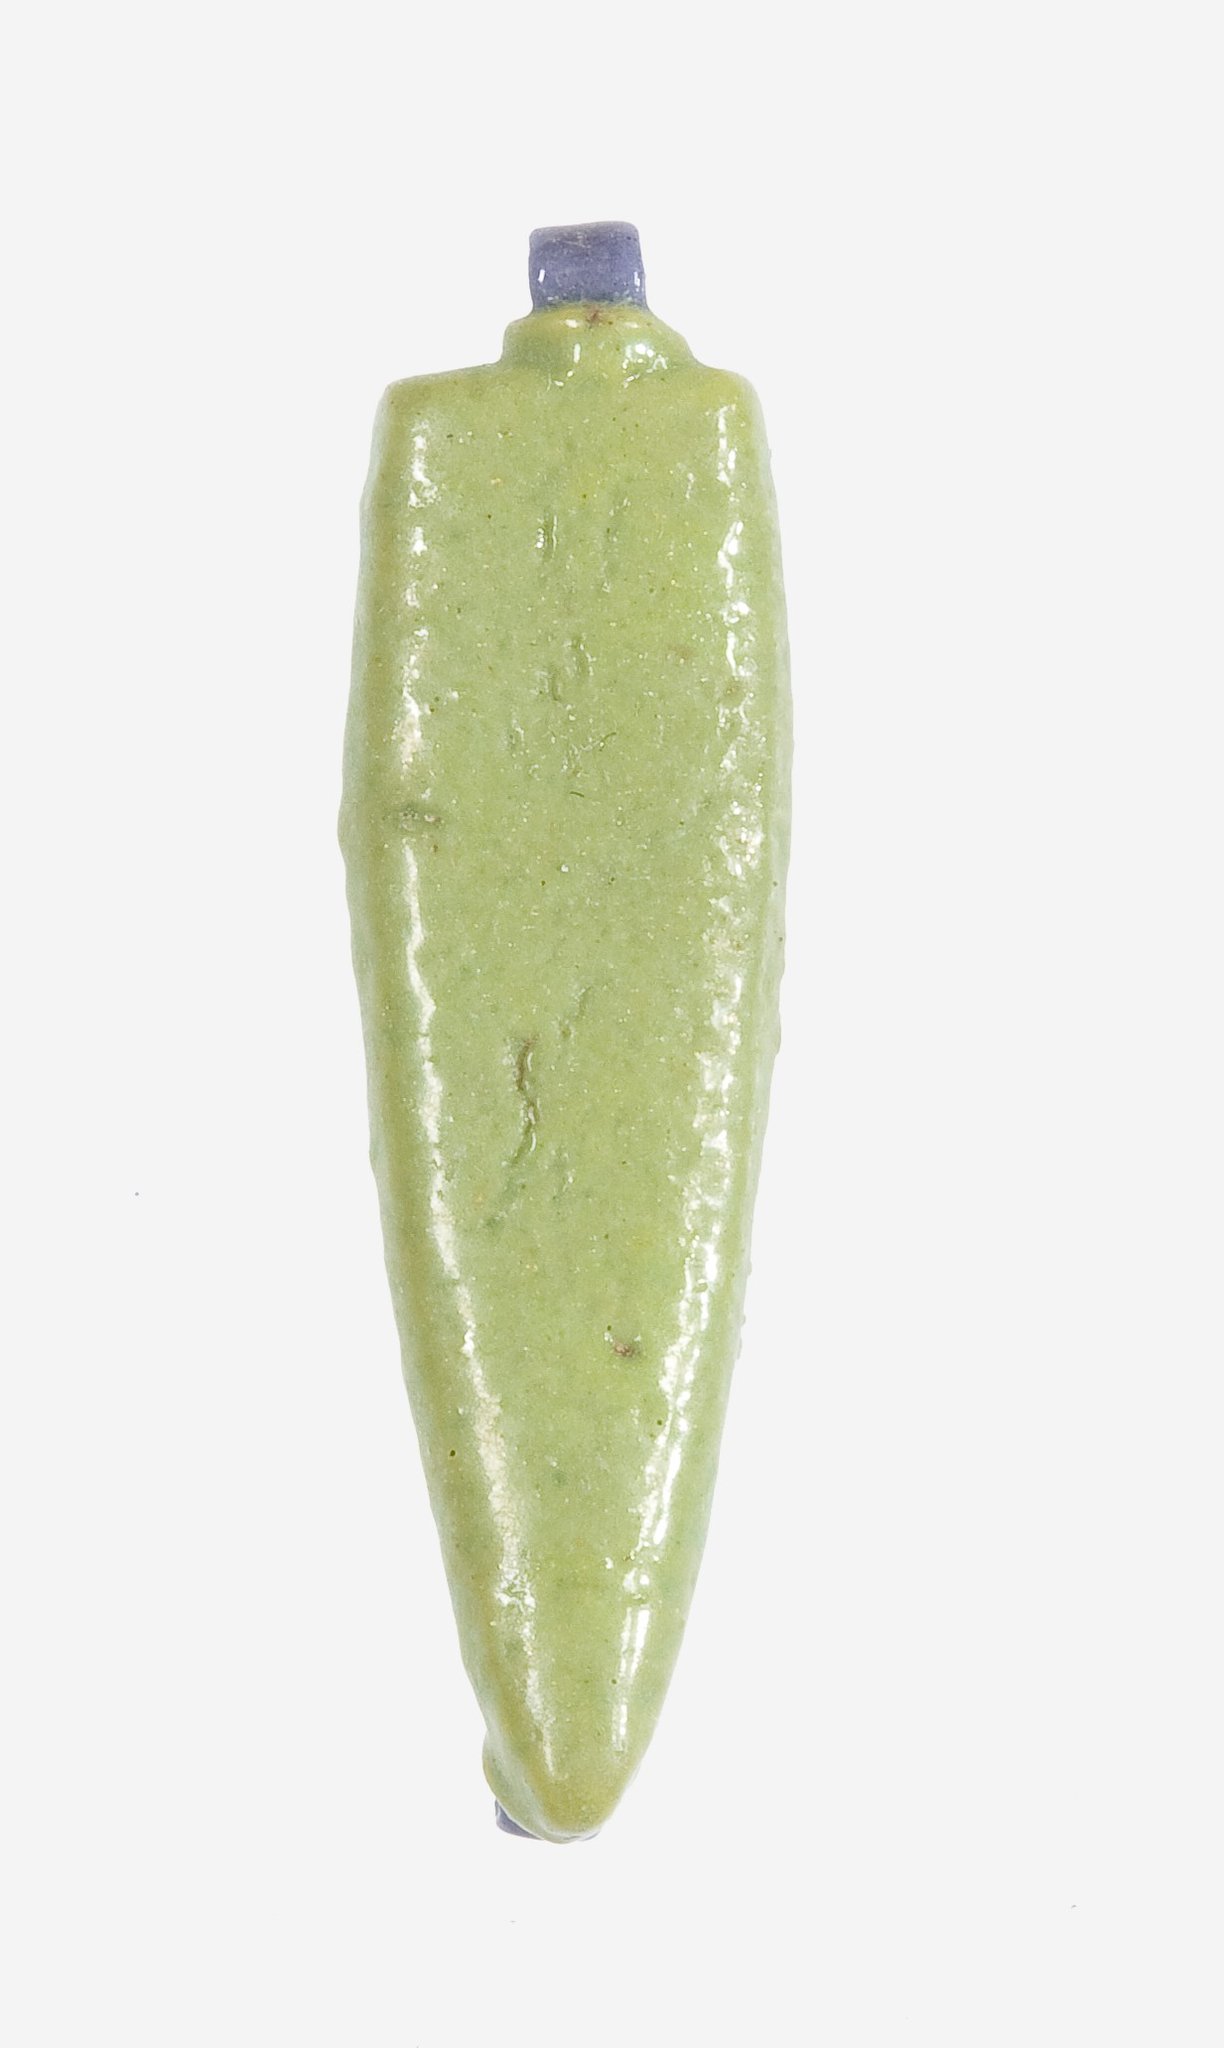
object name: pendant, leaf petal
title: Pendant: Lotus Sepal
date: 1390-1352 BCE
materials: faience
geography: egypt